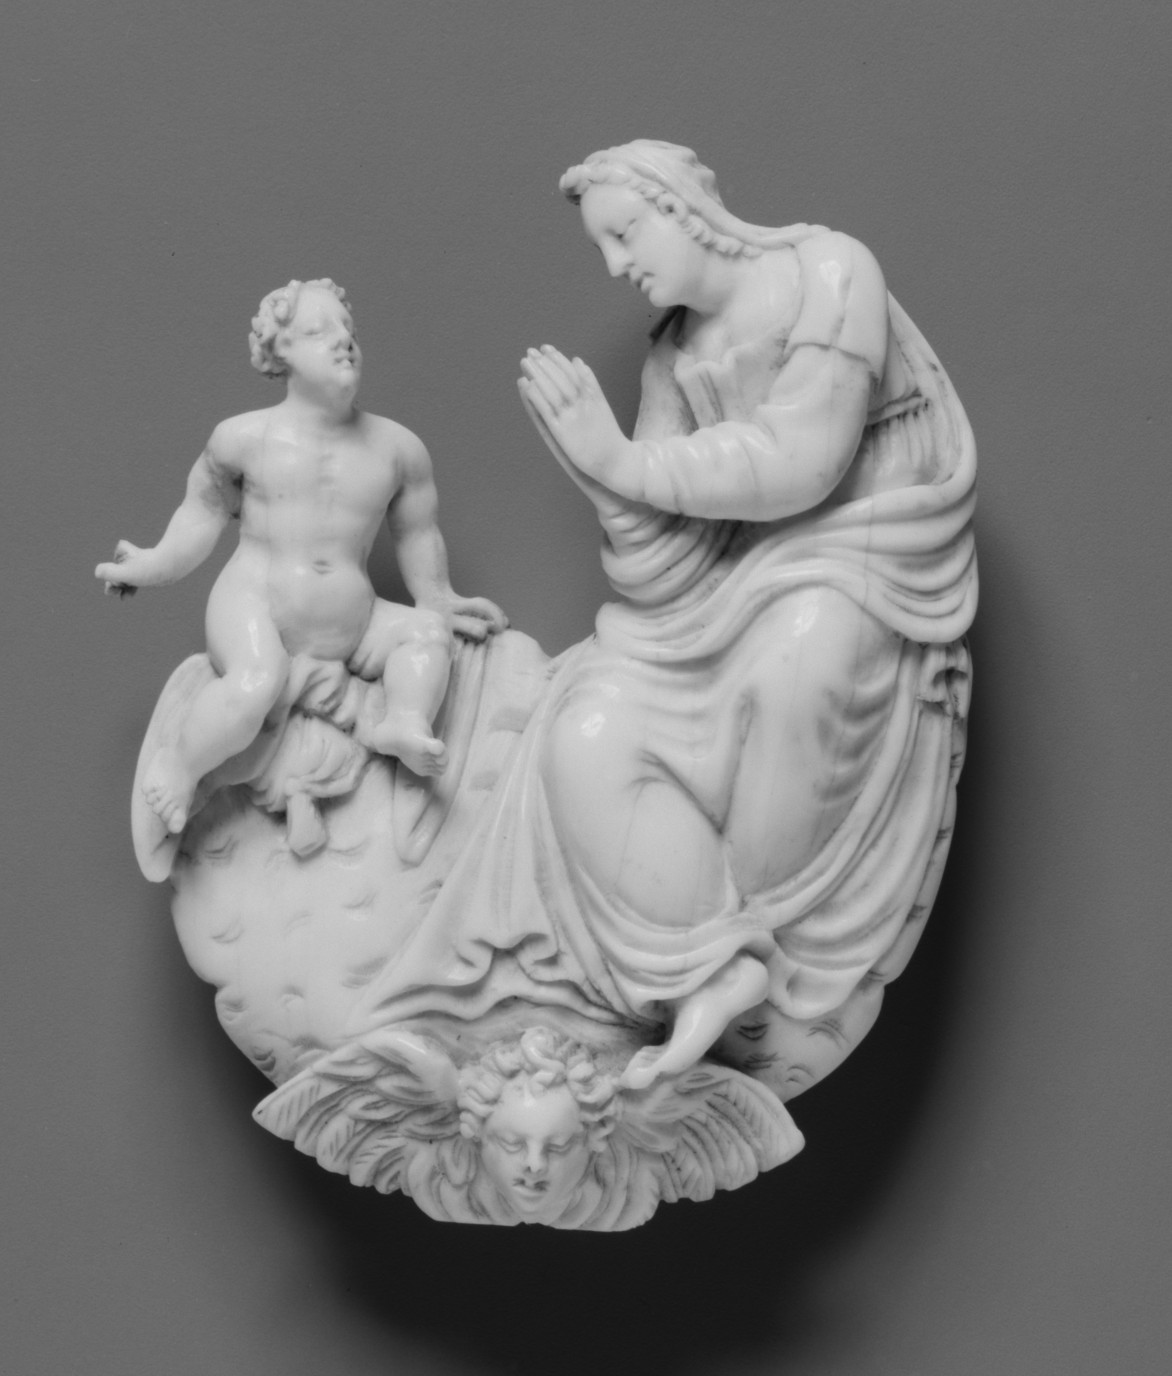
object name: plaque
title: Virgin adoring the Christ Child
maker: lelio orsi (called lelio da novellara)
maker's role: artist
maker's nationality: italian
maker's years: 1508-1587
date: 1601-1700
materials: ivory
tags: madonna and child